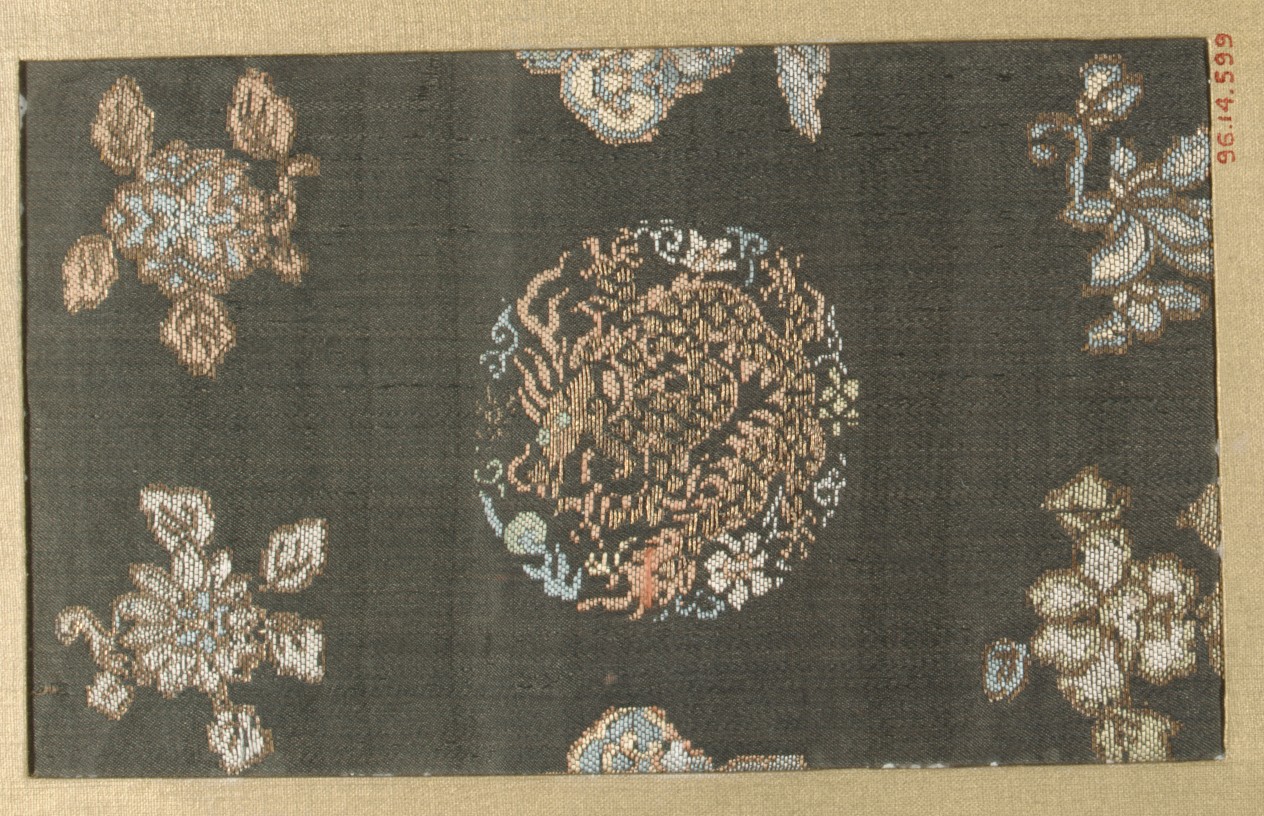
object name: piece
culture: chinese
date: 1701-1900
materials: silk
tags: flowers,leaves